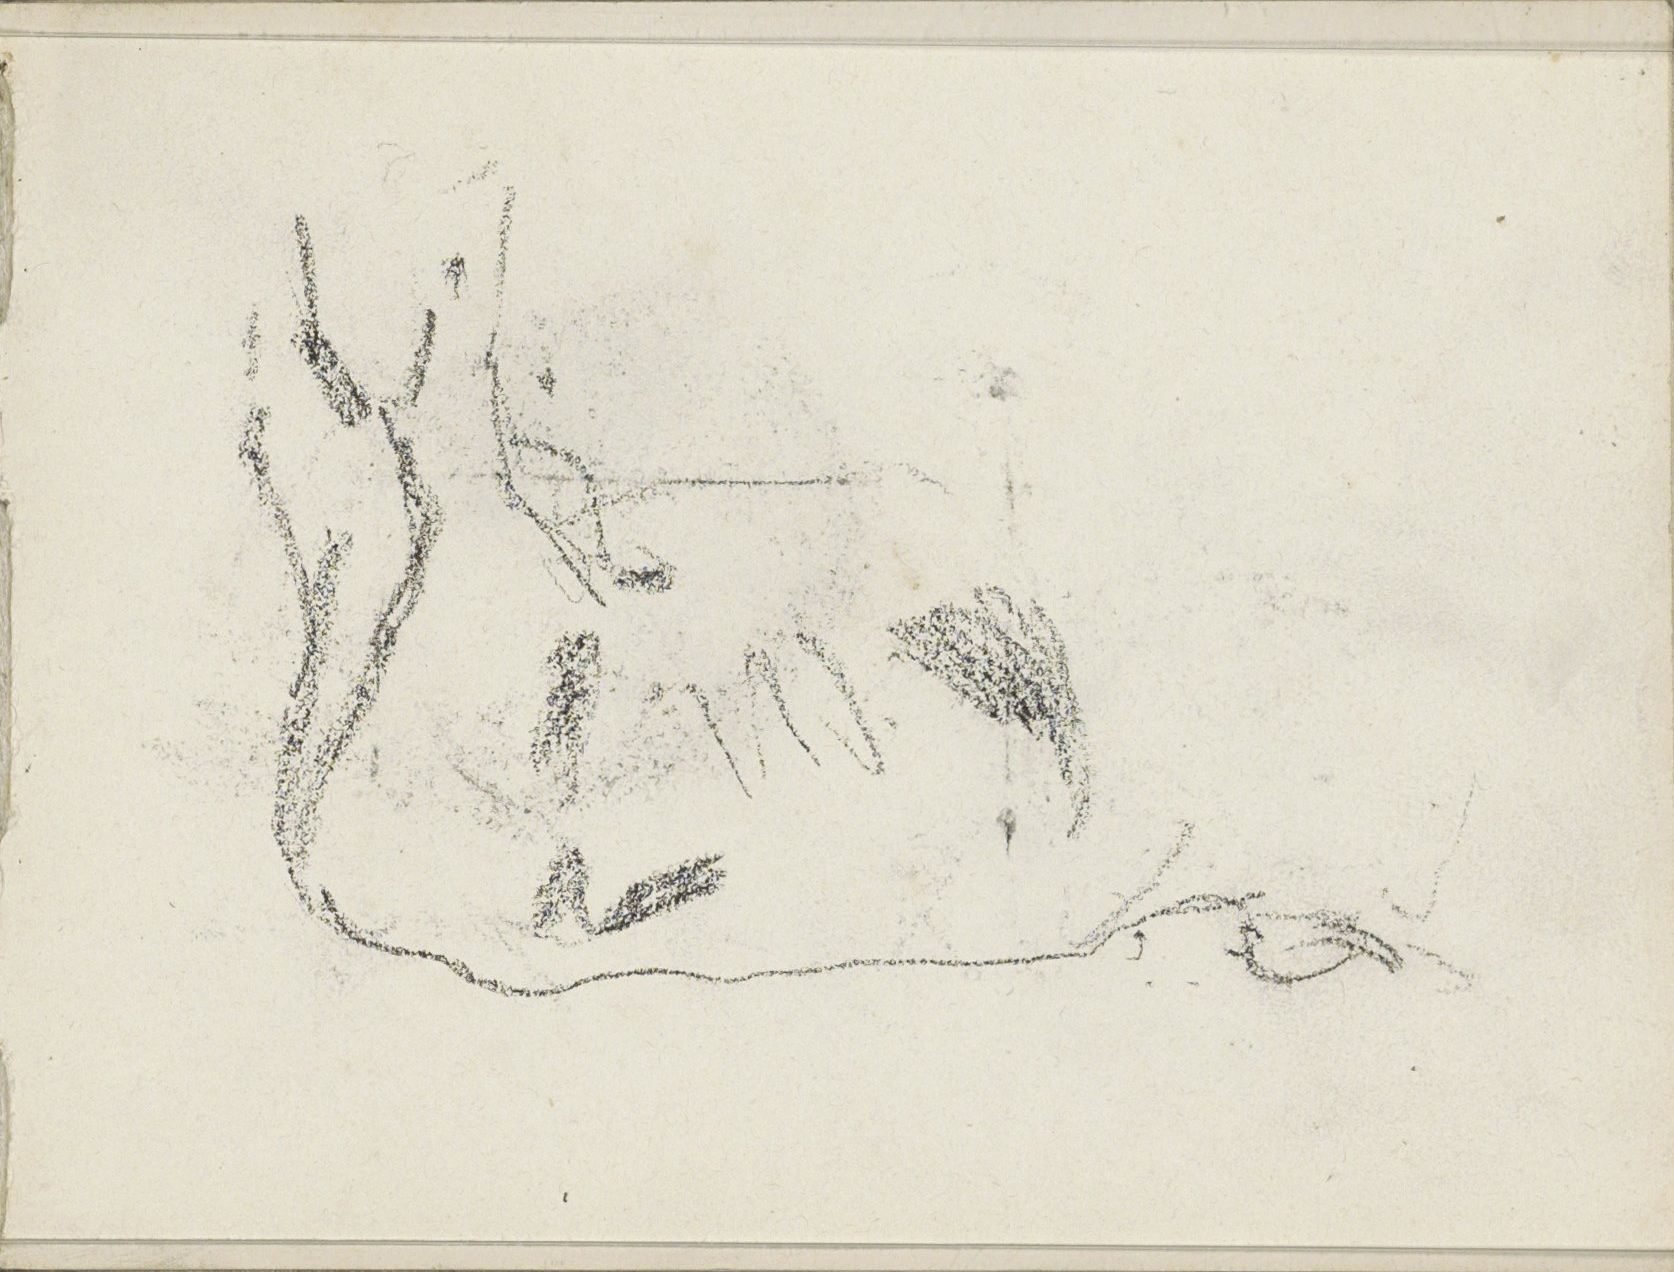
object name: sketchbook leaf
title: Achterlijf van een gevlekte koe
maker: anton mauve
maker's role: draughtsman, painter, print maker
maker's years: 1838-1888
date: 1881-1888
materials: chalk, paper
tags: cow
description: Blad 28 recto uit een schetsboek met 29 bladen.